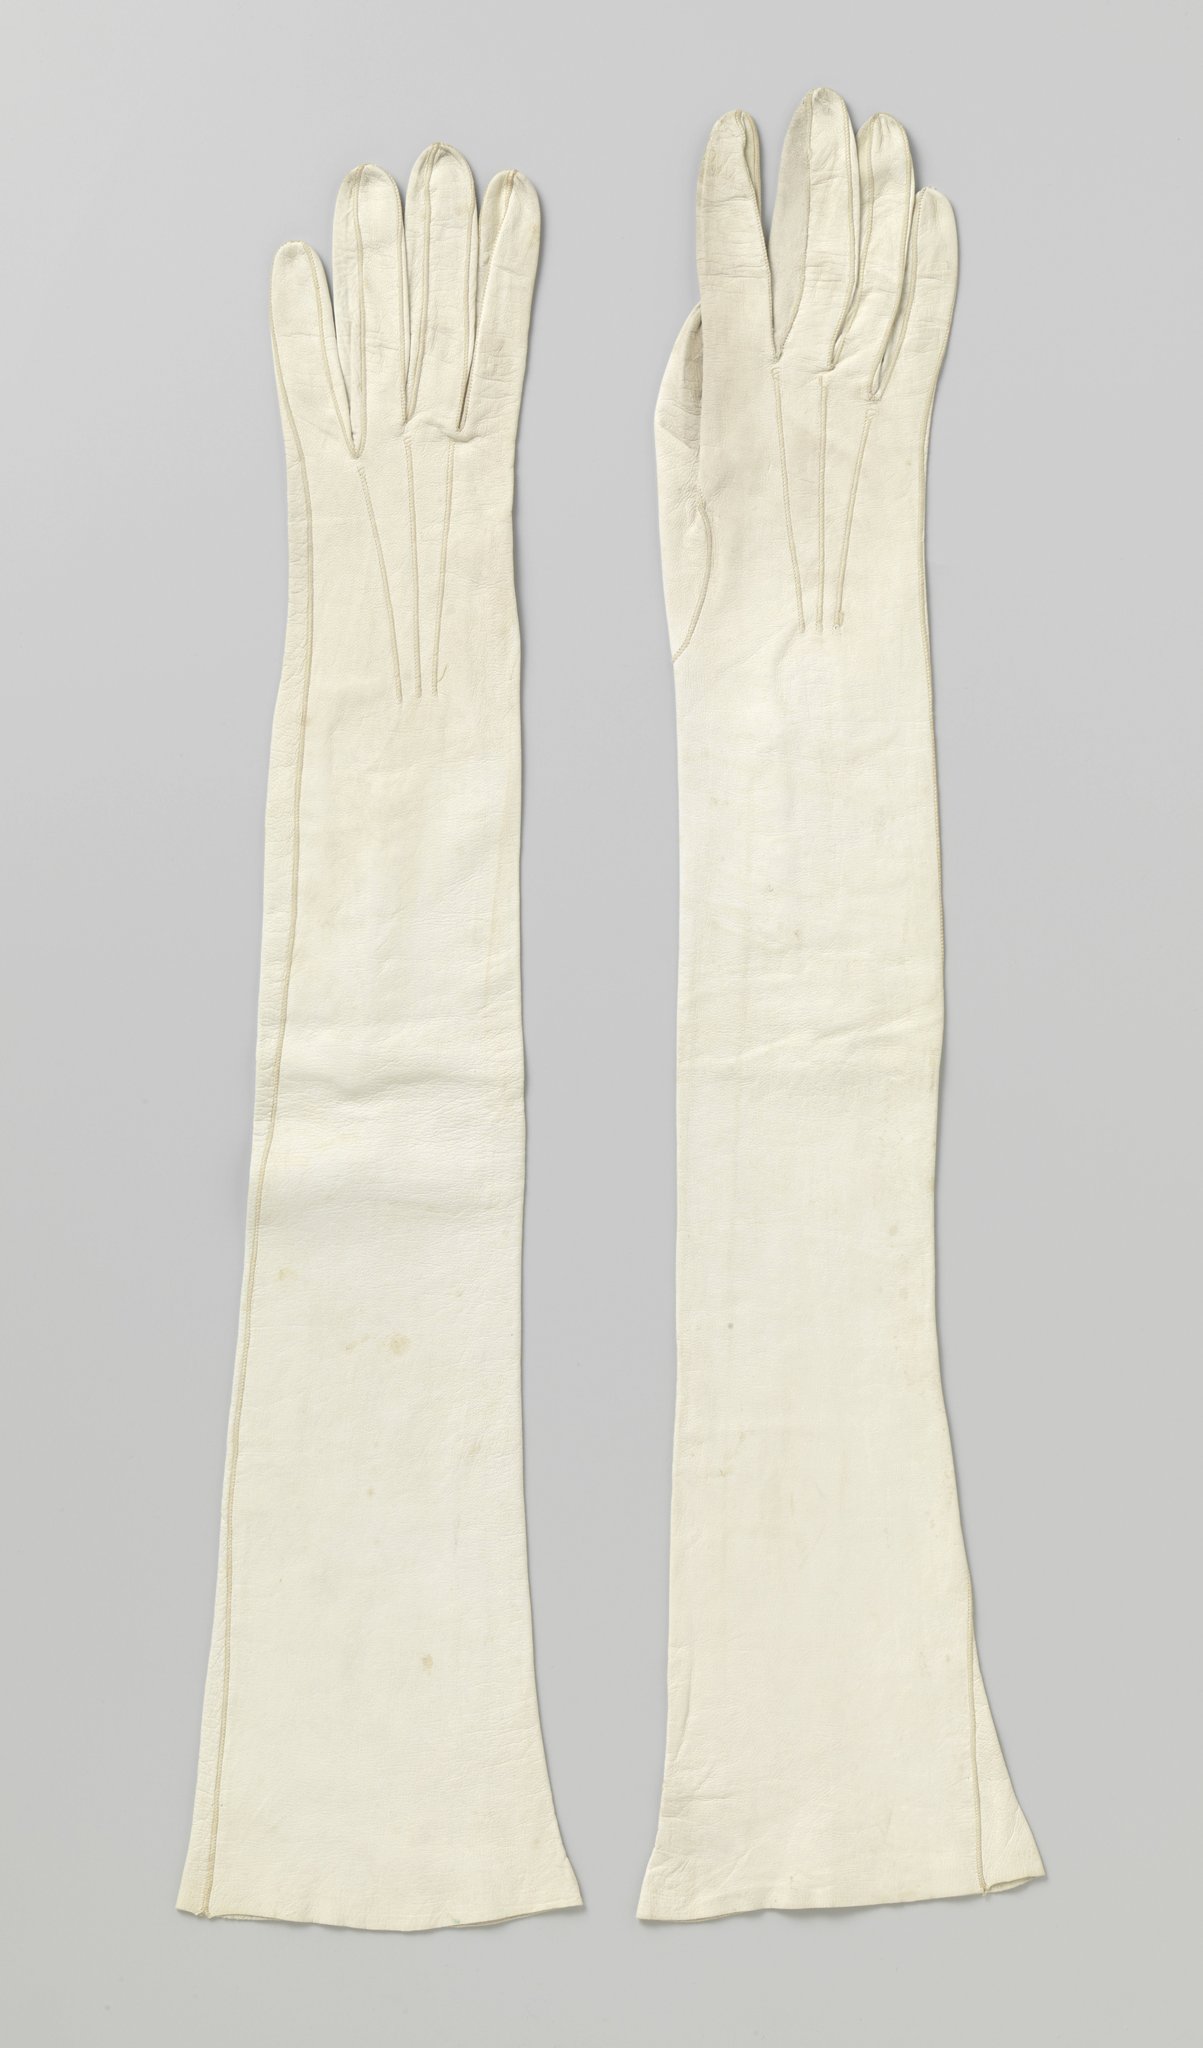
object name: clothing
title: Handschoen van wit kalfsleer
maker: Anonymous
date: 1900-1925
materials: leather, cotton, mother of pearl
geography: netherlands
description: Paar lange handschoenen van wit kalfsleer, met knoopsluiting. Gemerkt met inkt: Crone J. R.3836.